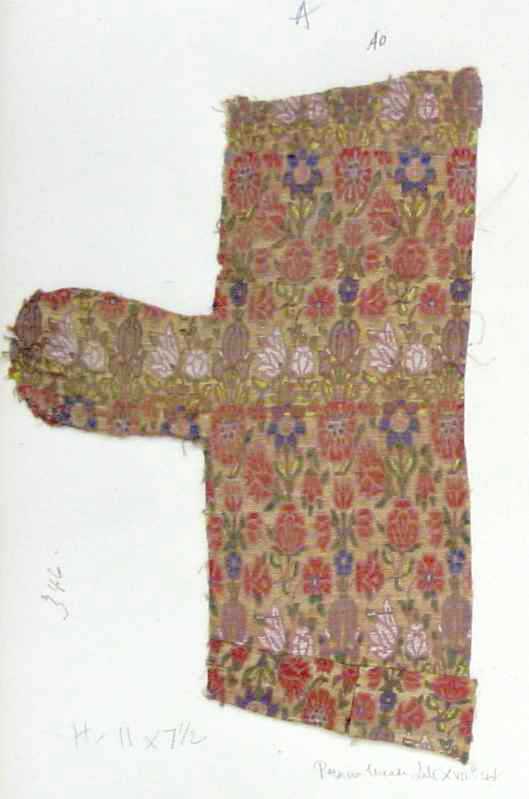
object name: textile fragment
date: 1601-1800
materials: metal thread, silk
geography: iran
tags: flowers